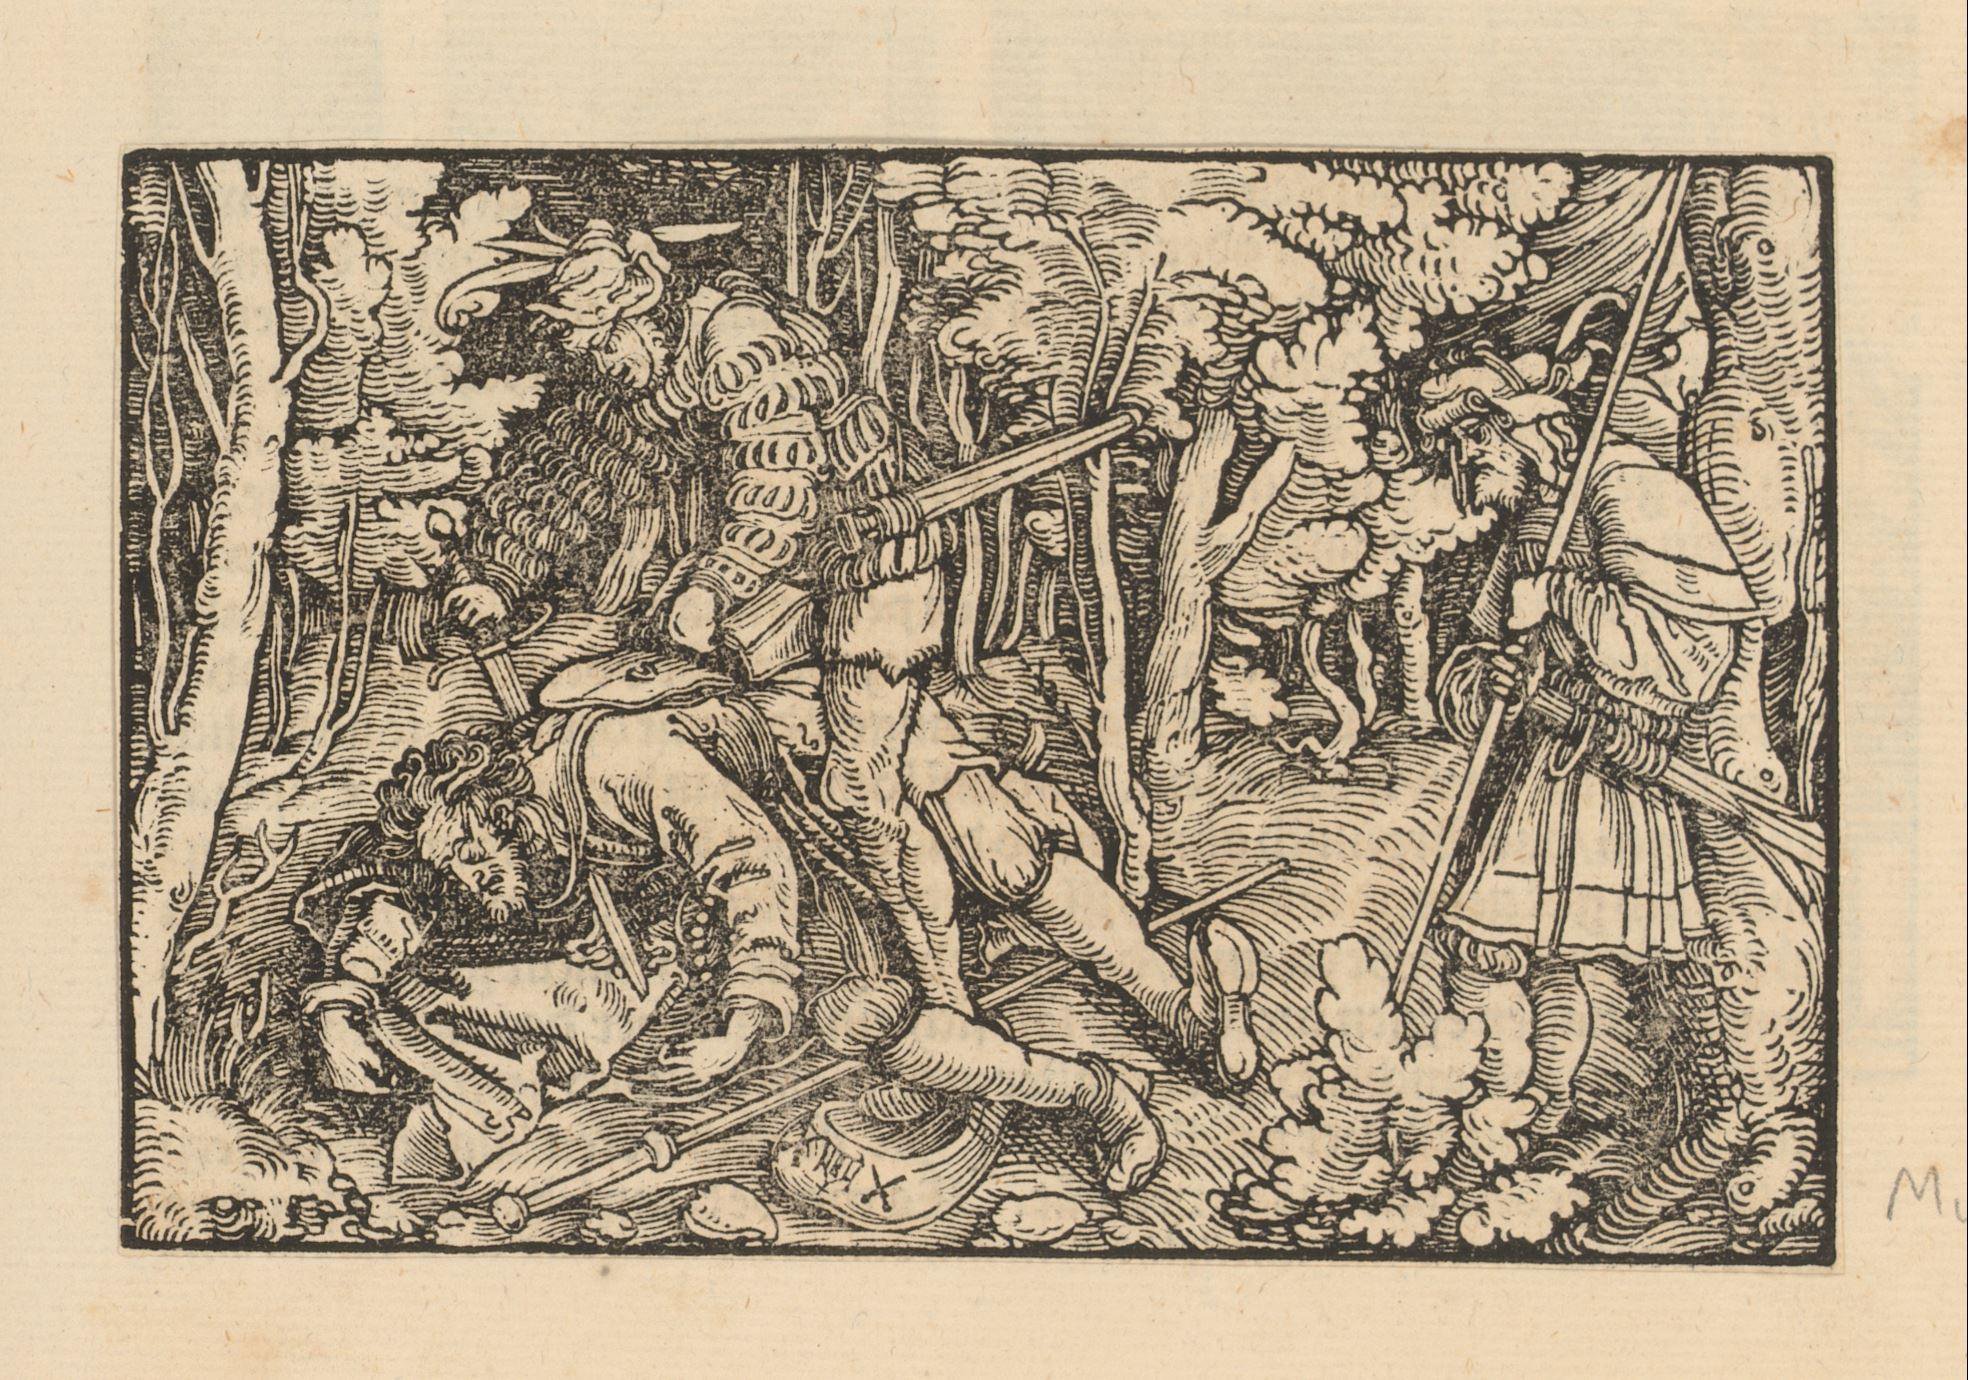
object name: album leaf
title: Landschap met moord op een pelgrim door twee gewapende mannen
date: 1514-1531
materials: paper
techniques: letterpress printing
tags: murder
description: Deze prent is gebruikt in: Cicero, Marcus Tulius. Officia M.T.C. Ein Buch so Marcus Tullius Cicero der Römer zu seynem (...). [Vertaald uit het Latijn door] Johann von Schwarzenberg. Augsburg: Heinrich Steiner, 1531.